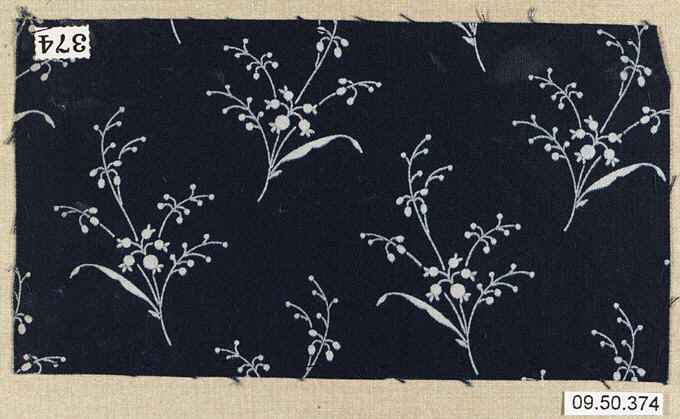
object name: piece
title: Piece (one of 116)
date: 1801-1900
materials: cotton